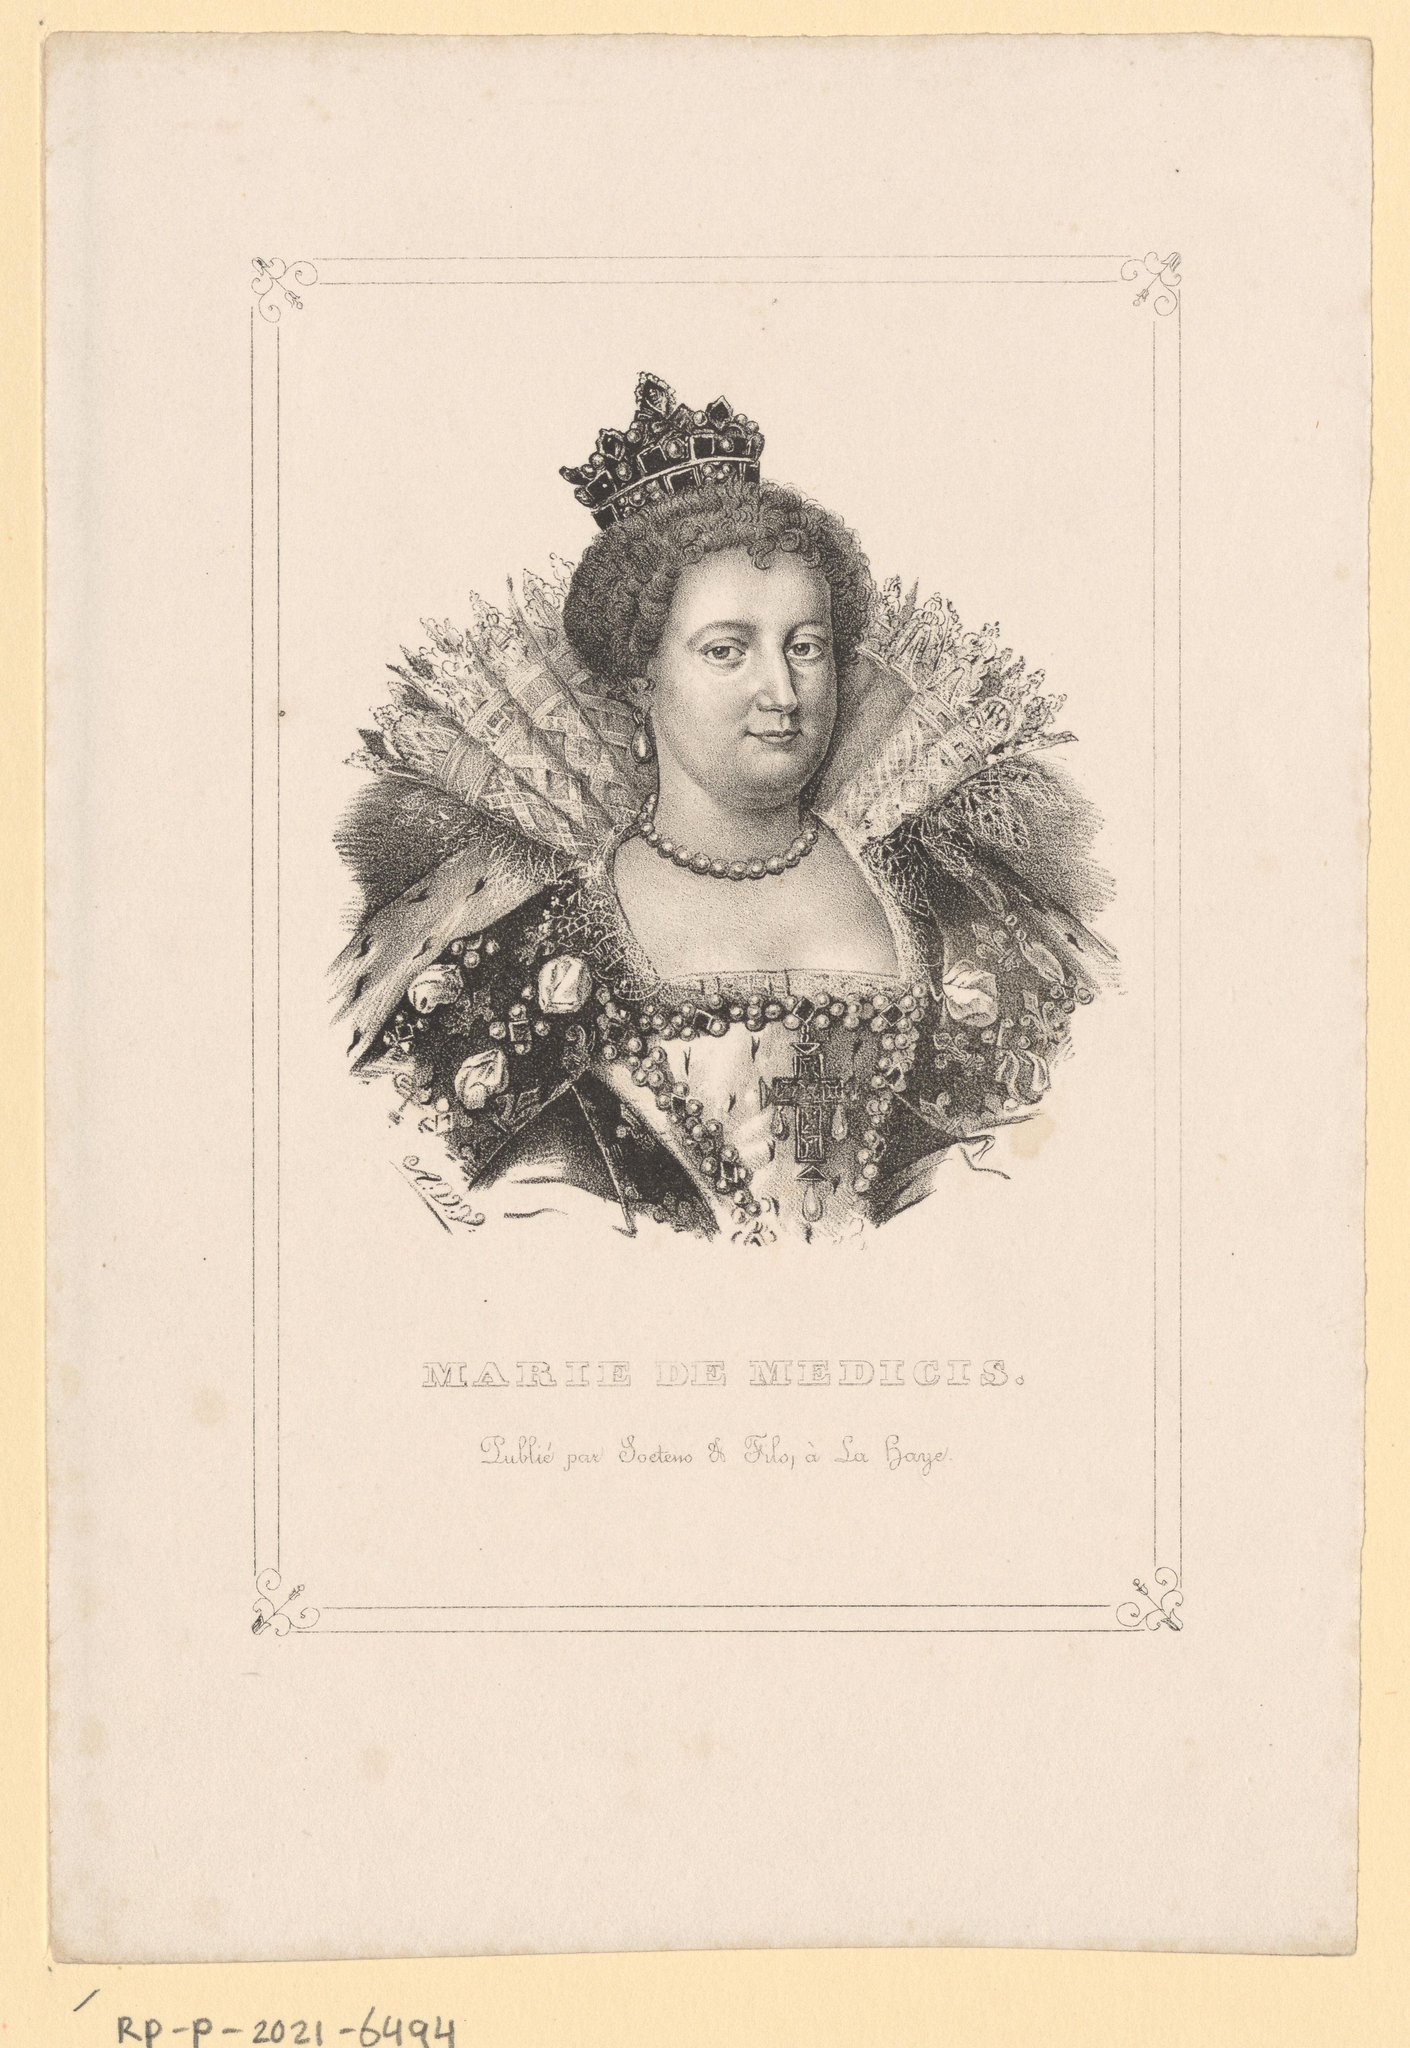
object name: print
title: Serie portretten door Soetens & Fils uit 1838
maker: anthonie van volkom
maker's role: print maker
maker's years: 1821-1860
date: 1837-1840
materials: paper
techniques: lithograph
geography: netherlands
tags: cologne, print maker, maria de' medici, historical persons - bb - woman, queen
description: Deze prent maakte waarschijnlijk deel uit van een serie uitgegeven door Soetens et Fils omstreeks 1838, opgedragen aan de Prins van Oranje. In de 'Prospectus en Inteekenlijst' stond vermeld dat het zal bestaan uit een onbepaald aantal portretten, waarvan er drie of vier per maand verschijnen. Zie Van Someren.